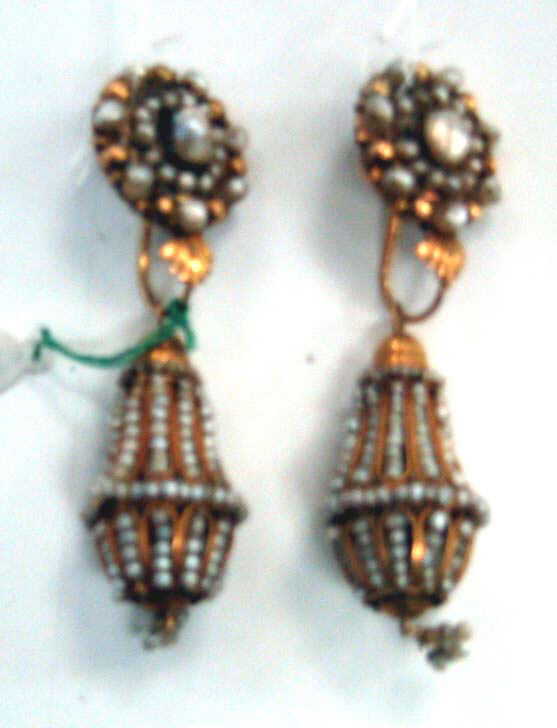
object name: earring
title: Earrings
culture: european, eastern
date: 1701-1900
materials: metal